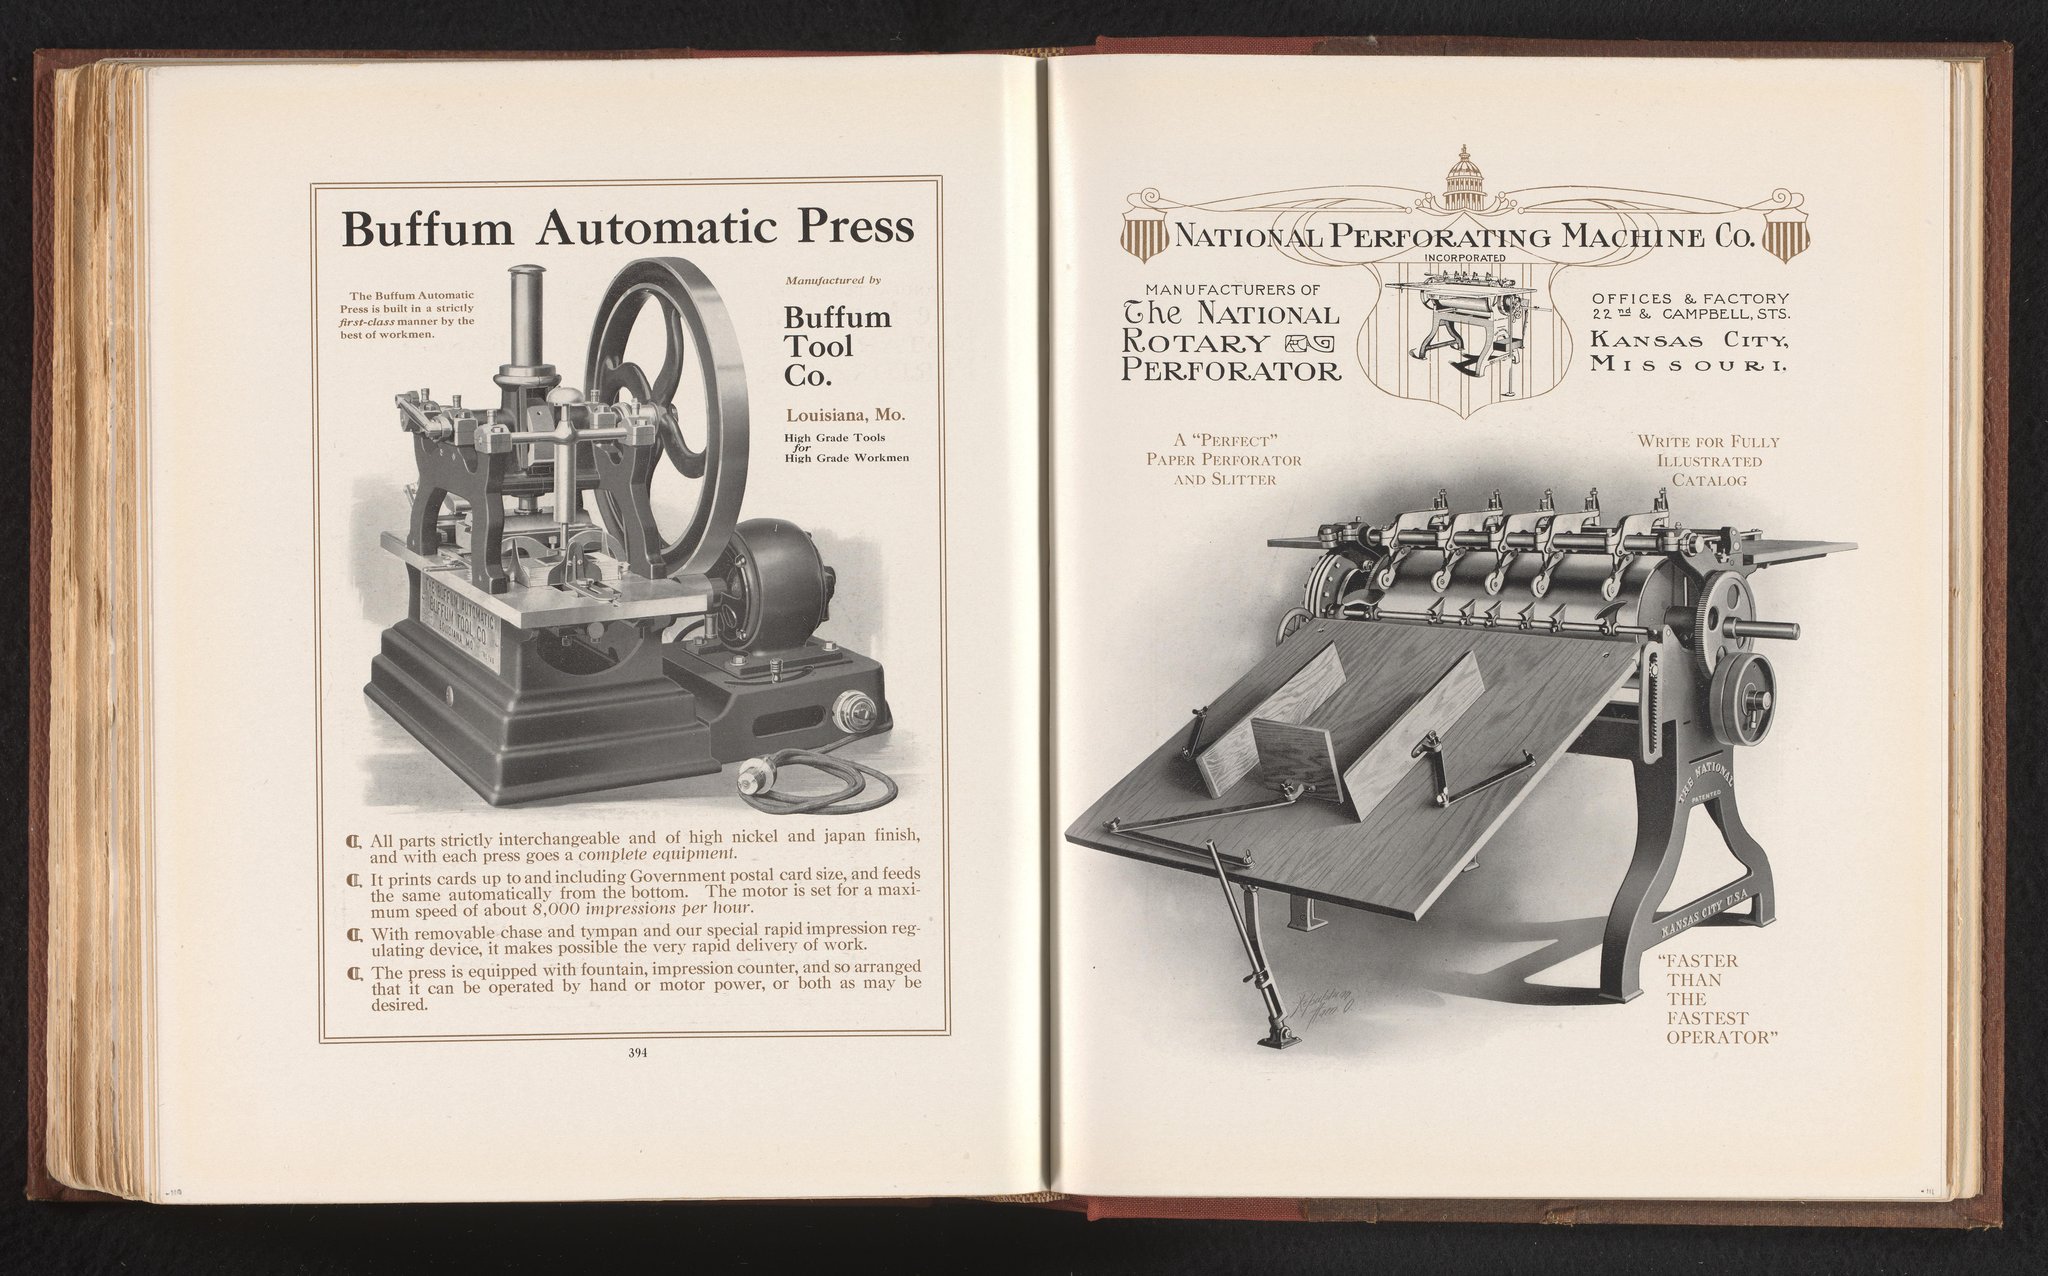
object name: page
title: Reclame voor de 'Buffum Automatic Press' van de Buffum Tool Co., Louisiana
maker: Anonymous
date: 1904-1909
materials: paper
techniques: autotype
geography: louisiana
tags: advertising, printing press